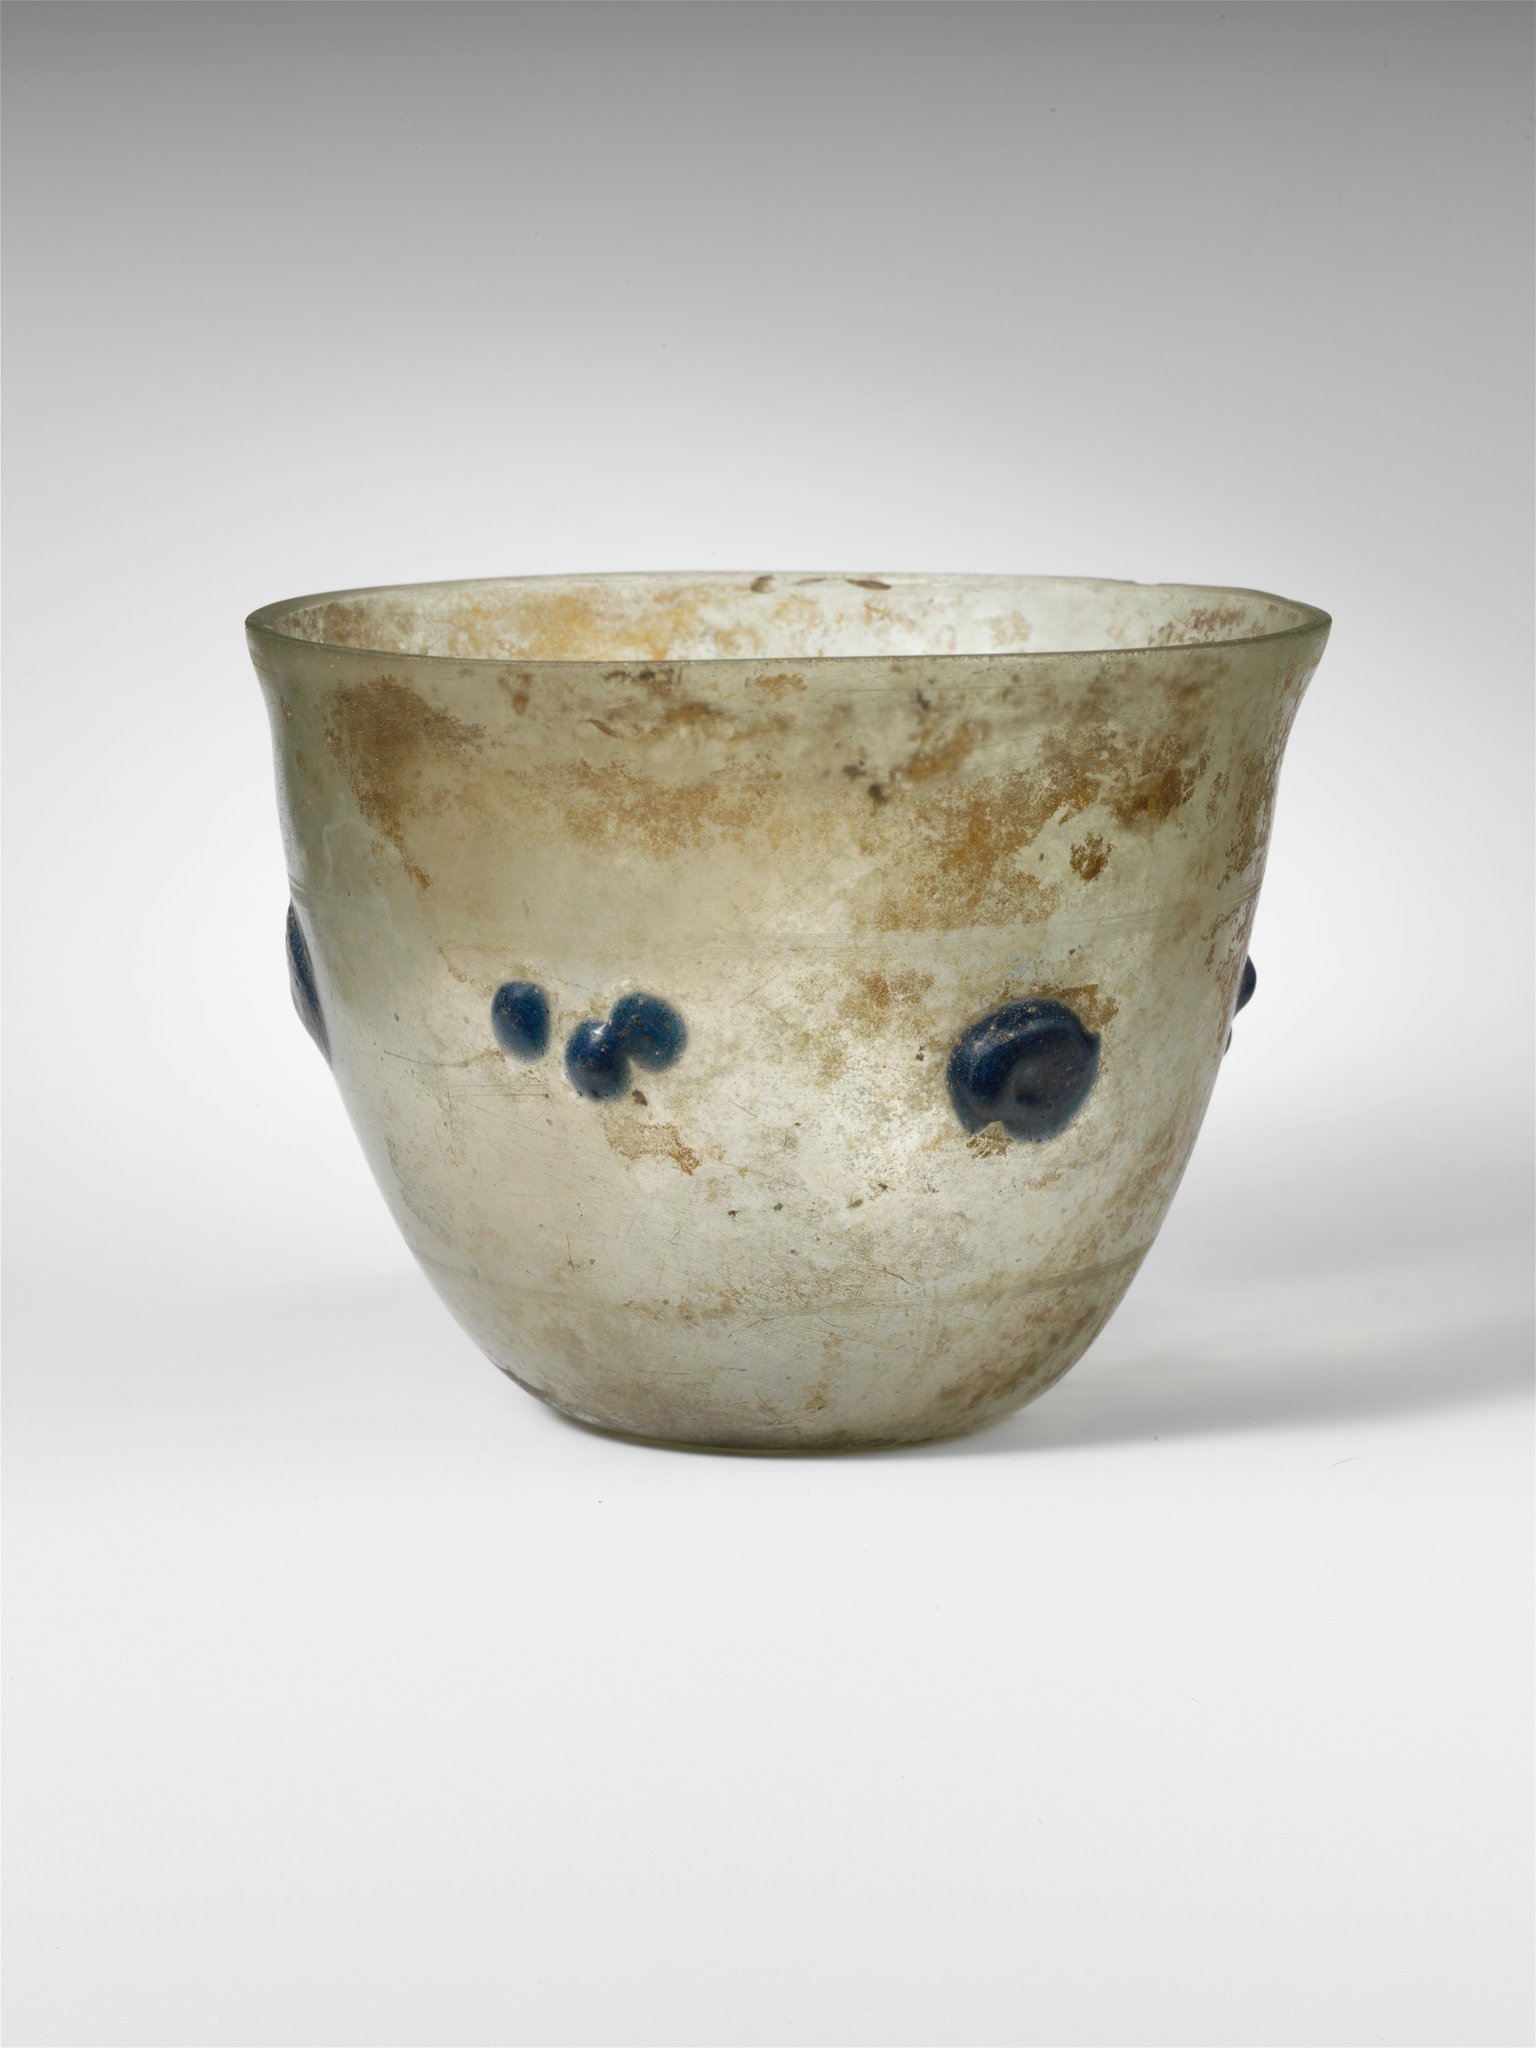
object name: beaker or lamp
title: Glass beaker or lamp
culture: roman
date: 301-400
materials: glass